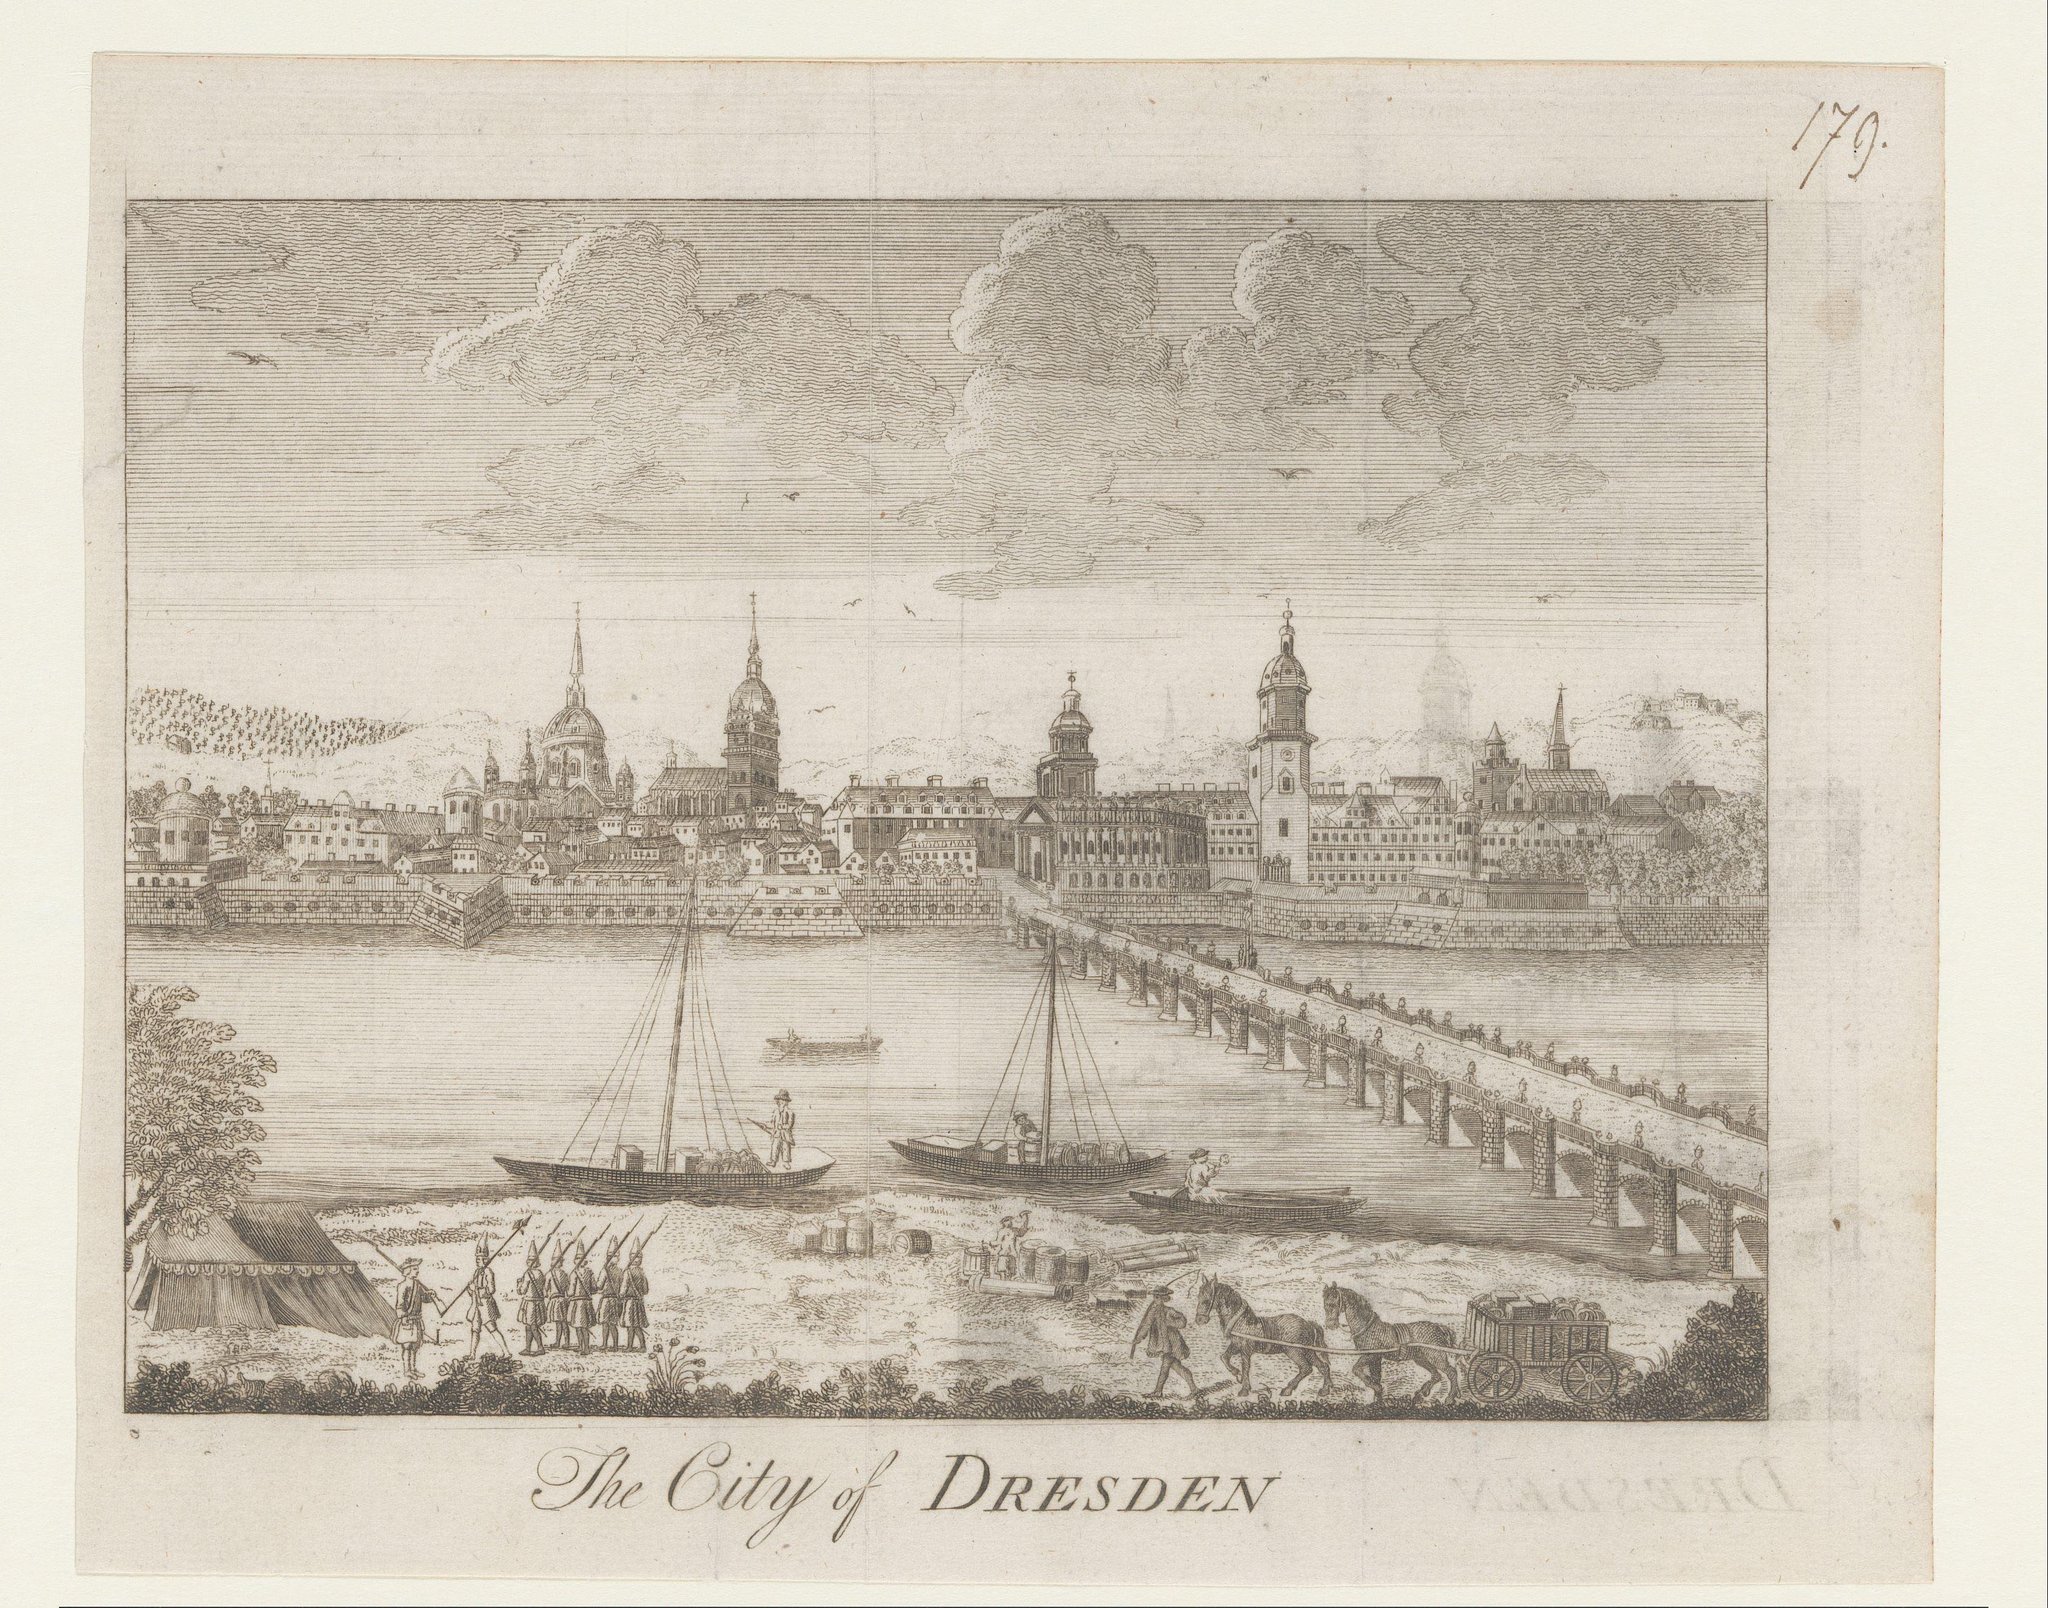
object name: print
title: Gezicht op Dresden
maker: anker smith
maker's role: print maker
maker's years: 1759-1819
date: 1787-1819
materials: paper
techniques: engraving, etching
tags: prospect of city, town panorama, silhouette of city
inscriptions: collector's mark: Lugt 2228